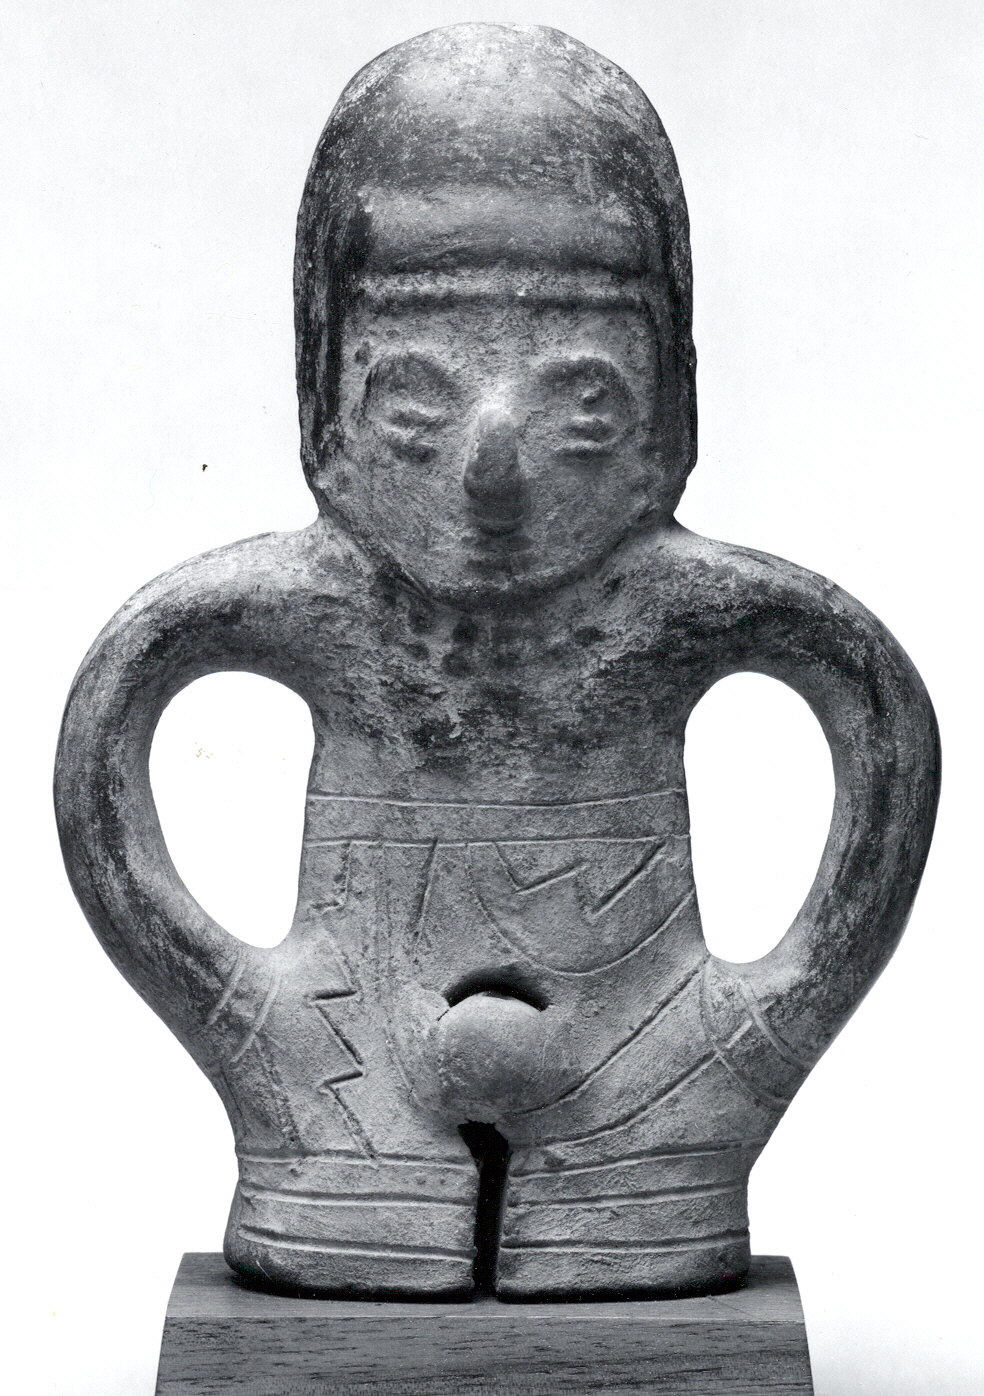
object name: whistle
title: Ceramic Whistle in the Form of a Standing Figure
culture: bahia or chorrera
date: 200 BCE-300 CE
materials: ceramic, pigment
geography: ecuador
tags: human figures,musical instruments